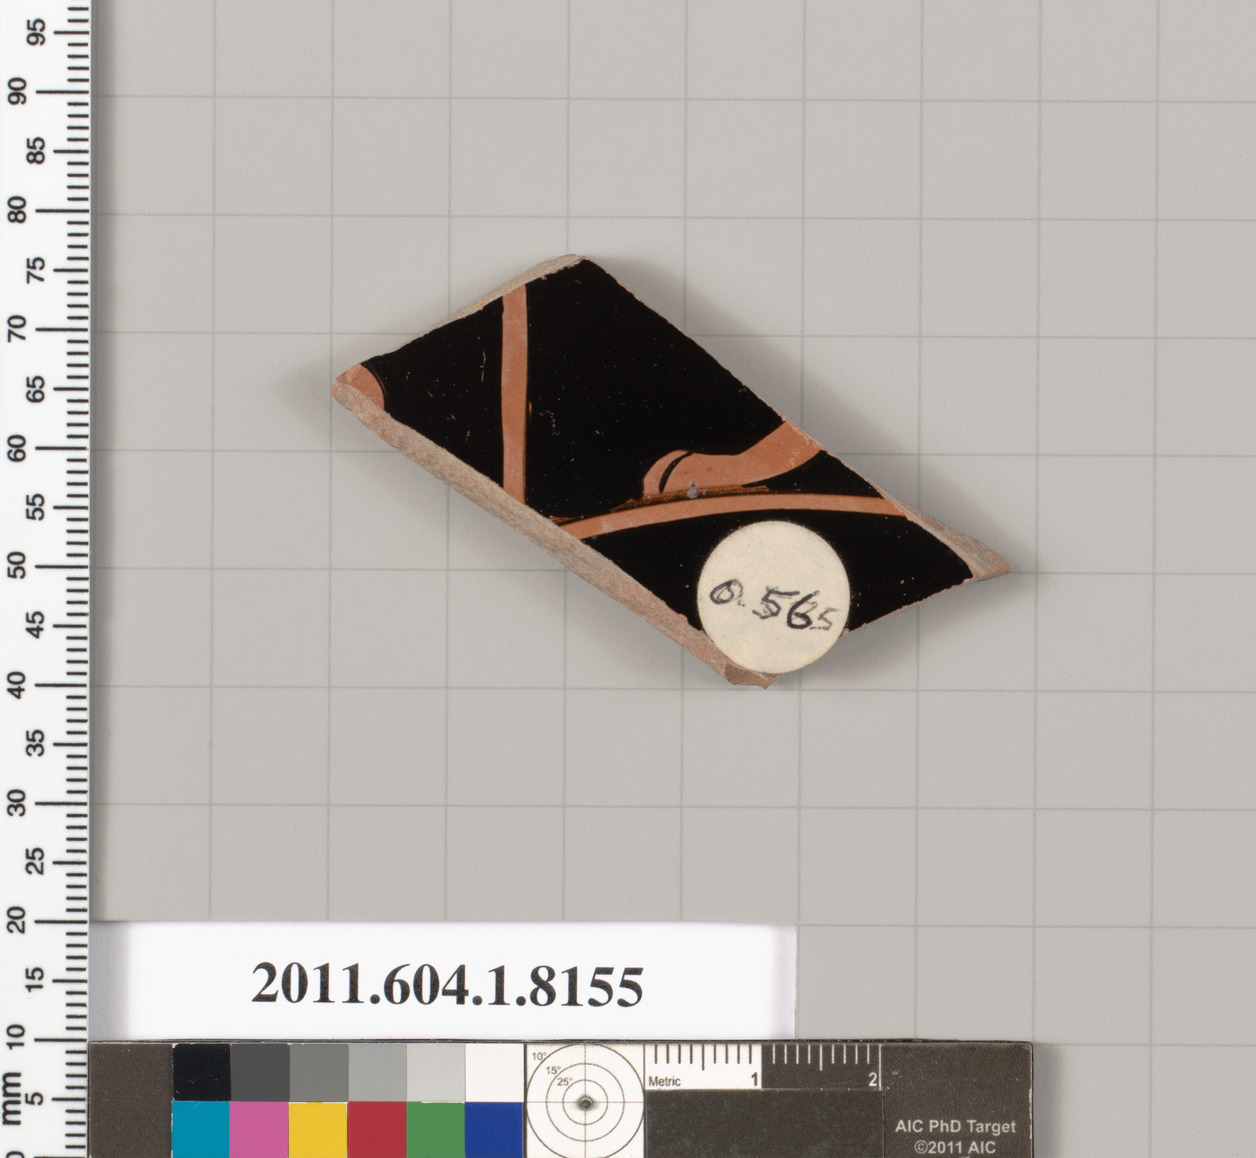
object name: kylix fragment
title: Terracotta fragment of a kylix (drinking cup)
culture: greek, attic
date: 520-500 BCE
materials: terracotta